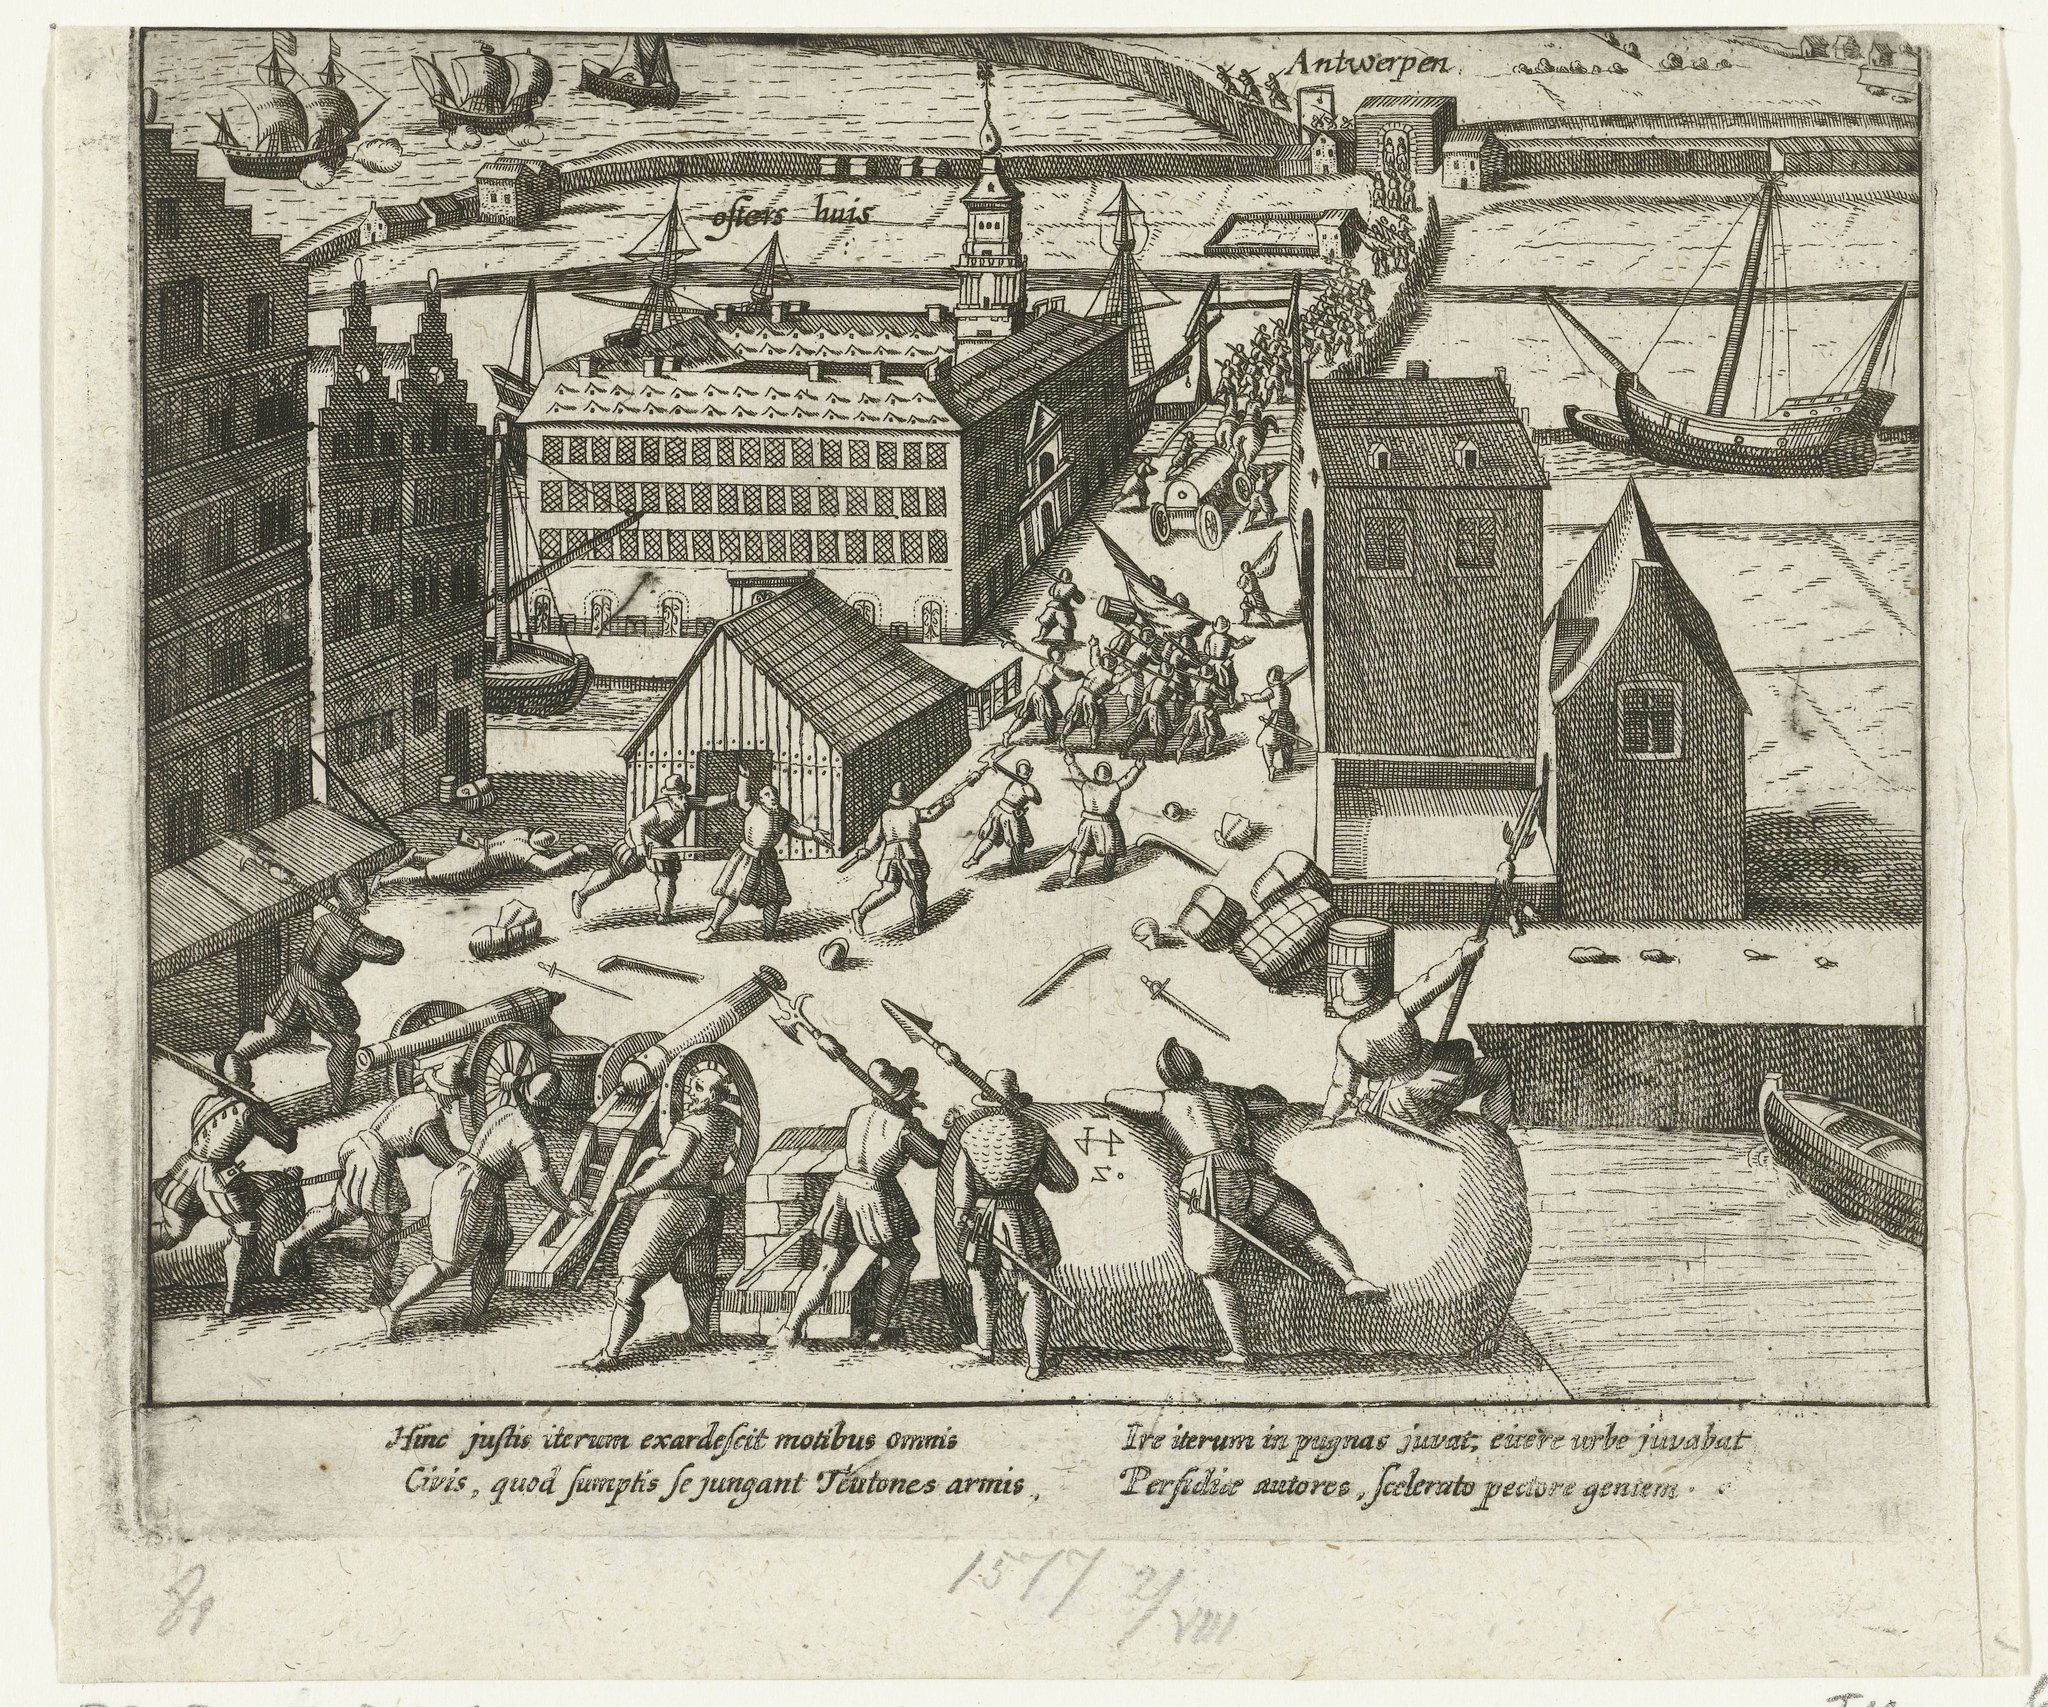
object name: print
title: Duitse troepen verlaten Antwerpen, 1577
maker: Anonymous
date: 1613-1615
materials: paper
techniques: etching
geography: northern netherlands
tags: citadel van antwerpen (16e eeuw), oostershuis, nieuwstad, strijd rond de citadel van antwerpen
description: De Duitse troepen trekken zich terug uit Antwerpen bij de Nieuwstad en het Oostershuis, 2 augustus 1577. Op de achtergrond rechts verlaten de Duitsers de stad, links aan de horizon de schepen van de vloot van de Prins. Met onderschrift van 4 regels in het Latijn. Het nummer weggekrabd en onbedrukt op achterzijde.